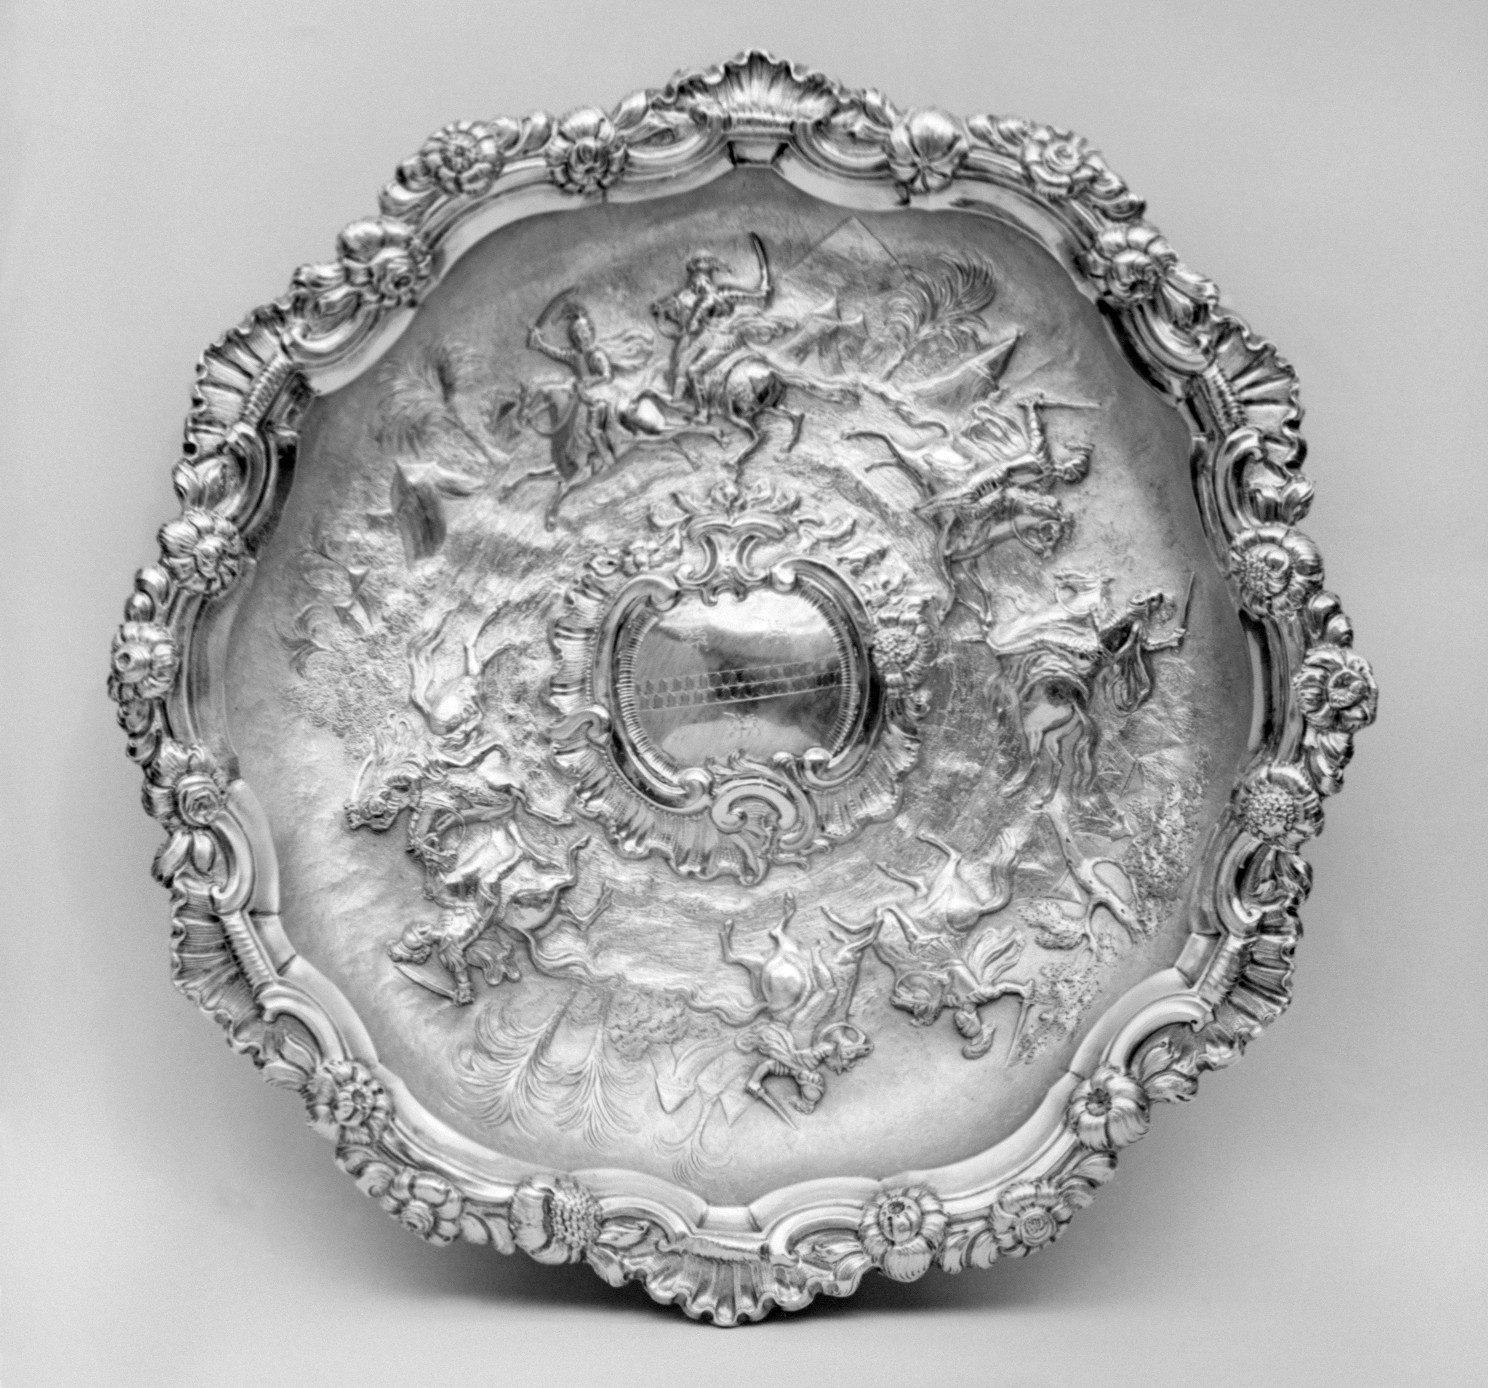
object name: dish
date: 1701-1900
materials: silver gilt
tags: swords,men,horses